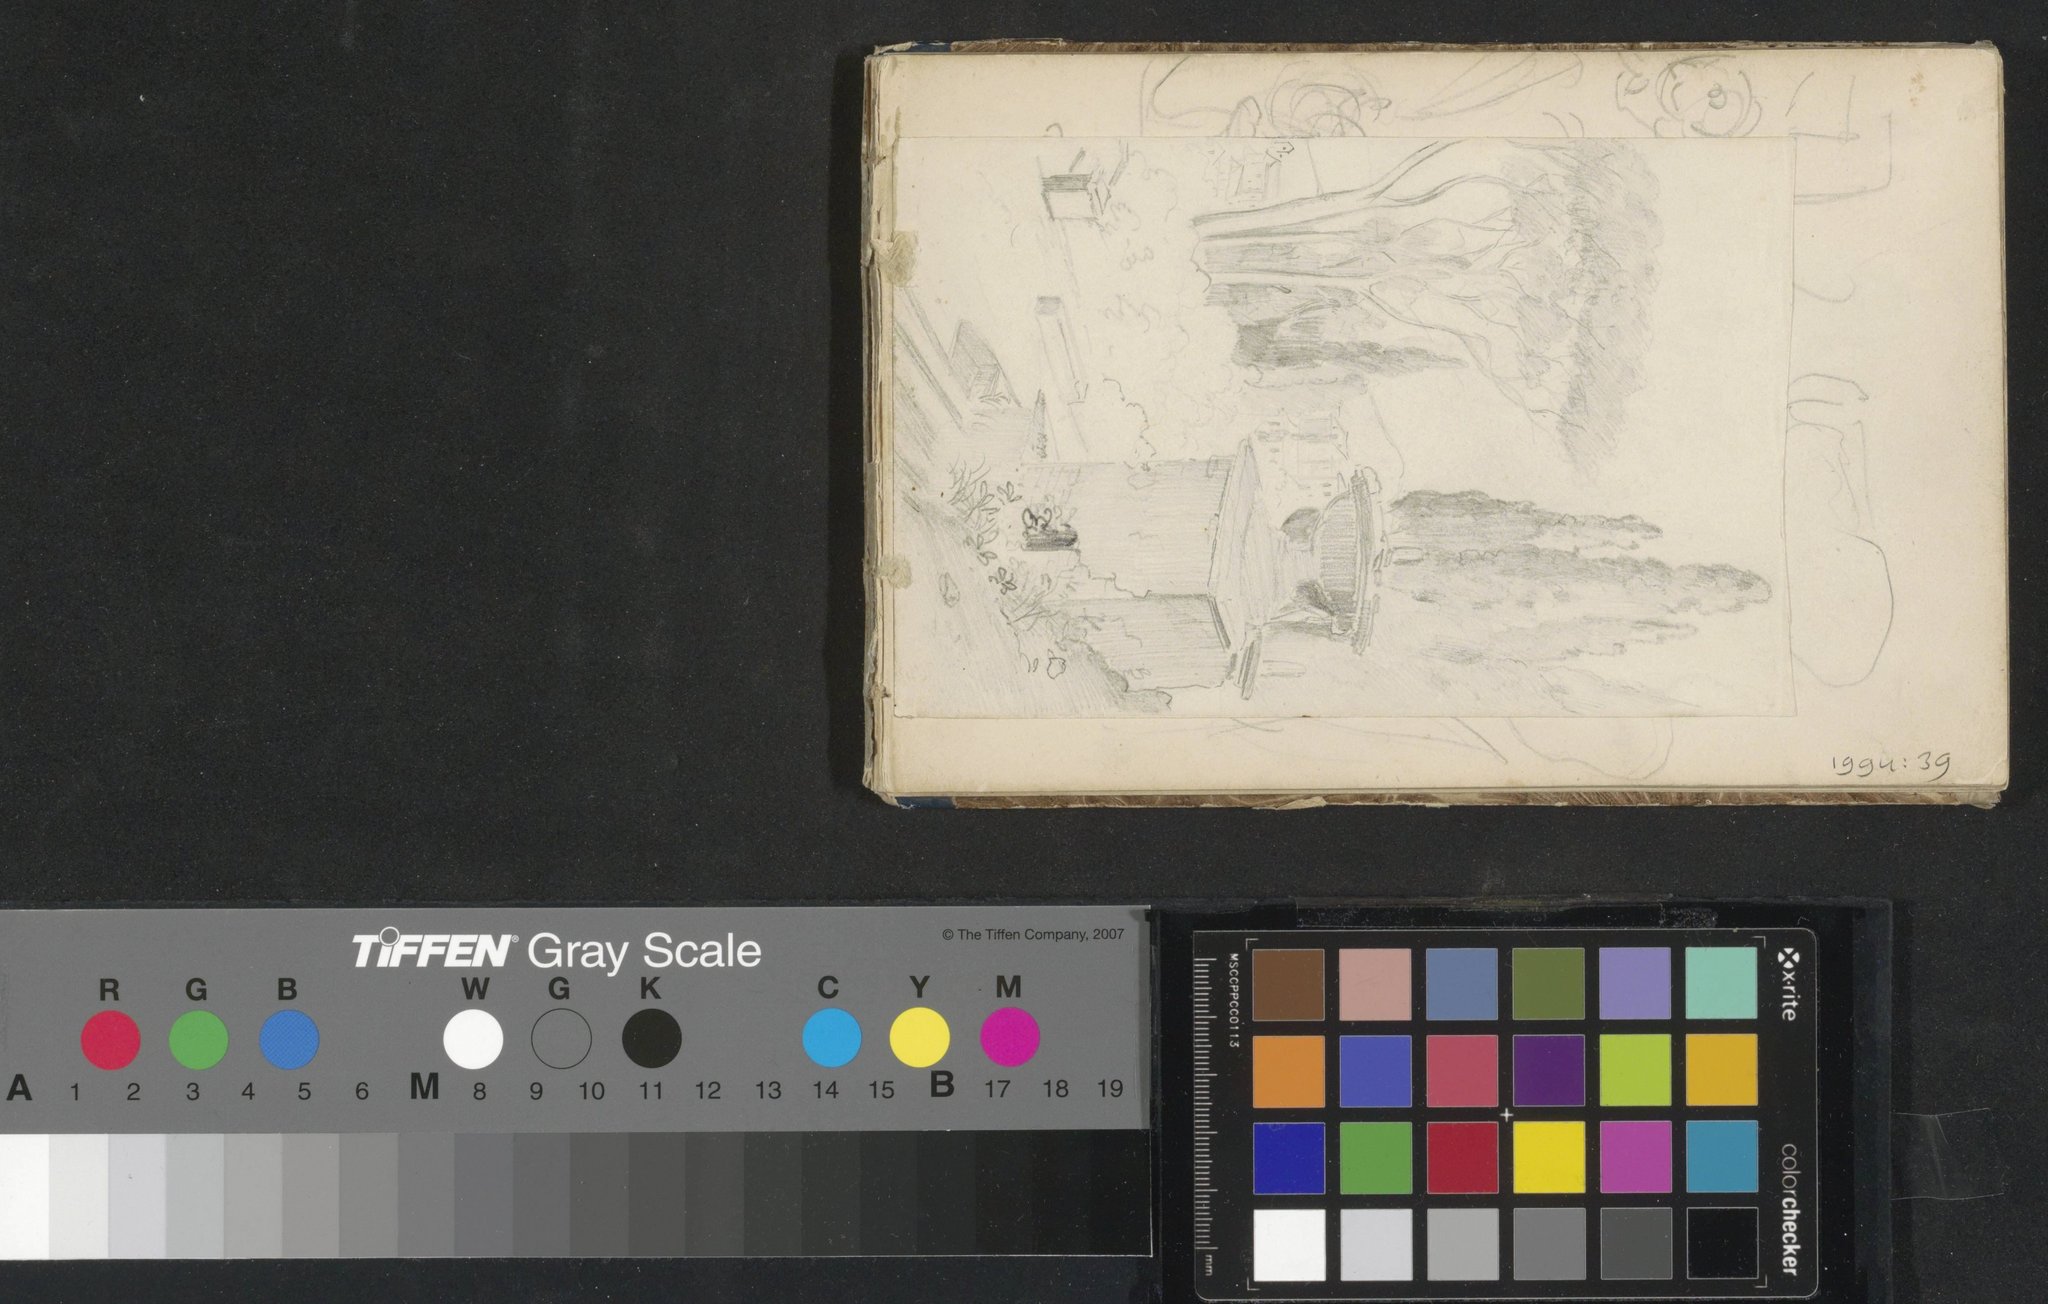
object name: sketchbook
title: Schetsboek met 33 bladen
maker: Anonymous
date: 1841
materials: cardboard, paper, pencil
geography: italy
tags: city-view, and landscape with man-made constructions, landscapes, animals, christian religion, rome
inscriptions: label: ‘44’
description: De volgende bladen uit het schetsboek zijn blanco: 2(V), 3(V), 4(V), 5(V), 6(V), 8(V), 9(V), 10(V), 11(V), 12(V), 13(V), 14(V), 17(V), 18(V), 20(V), 22(V), 24(V), 25, 26, 27(V), 28(V), 29(V), 30(V), 31(V)